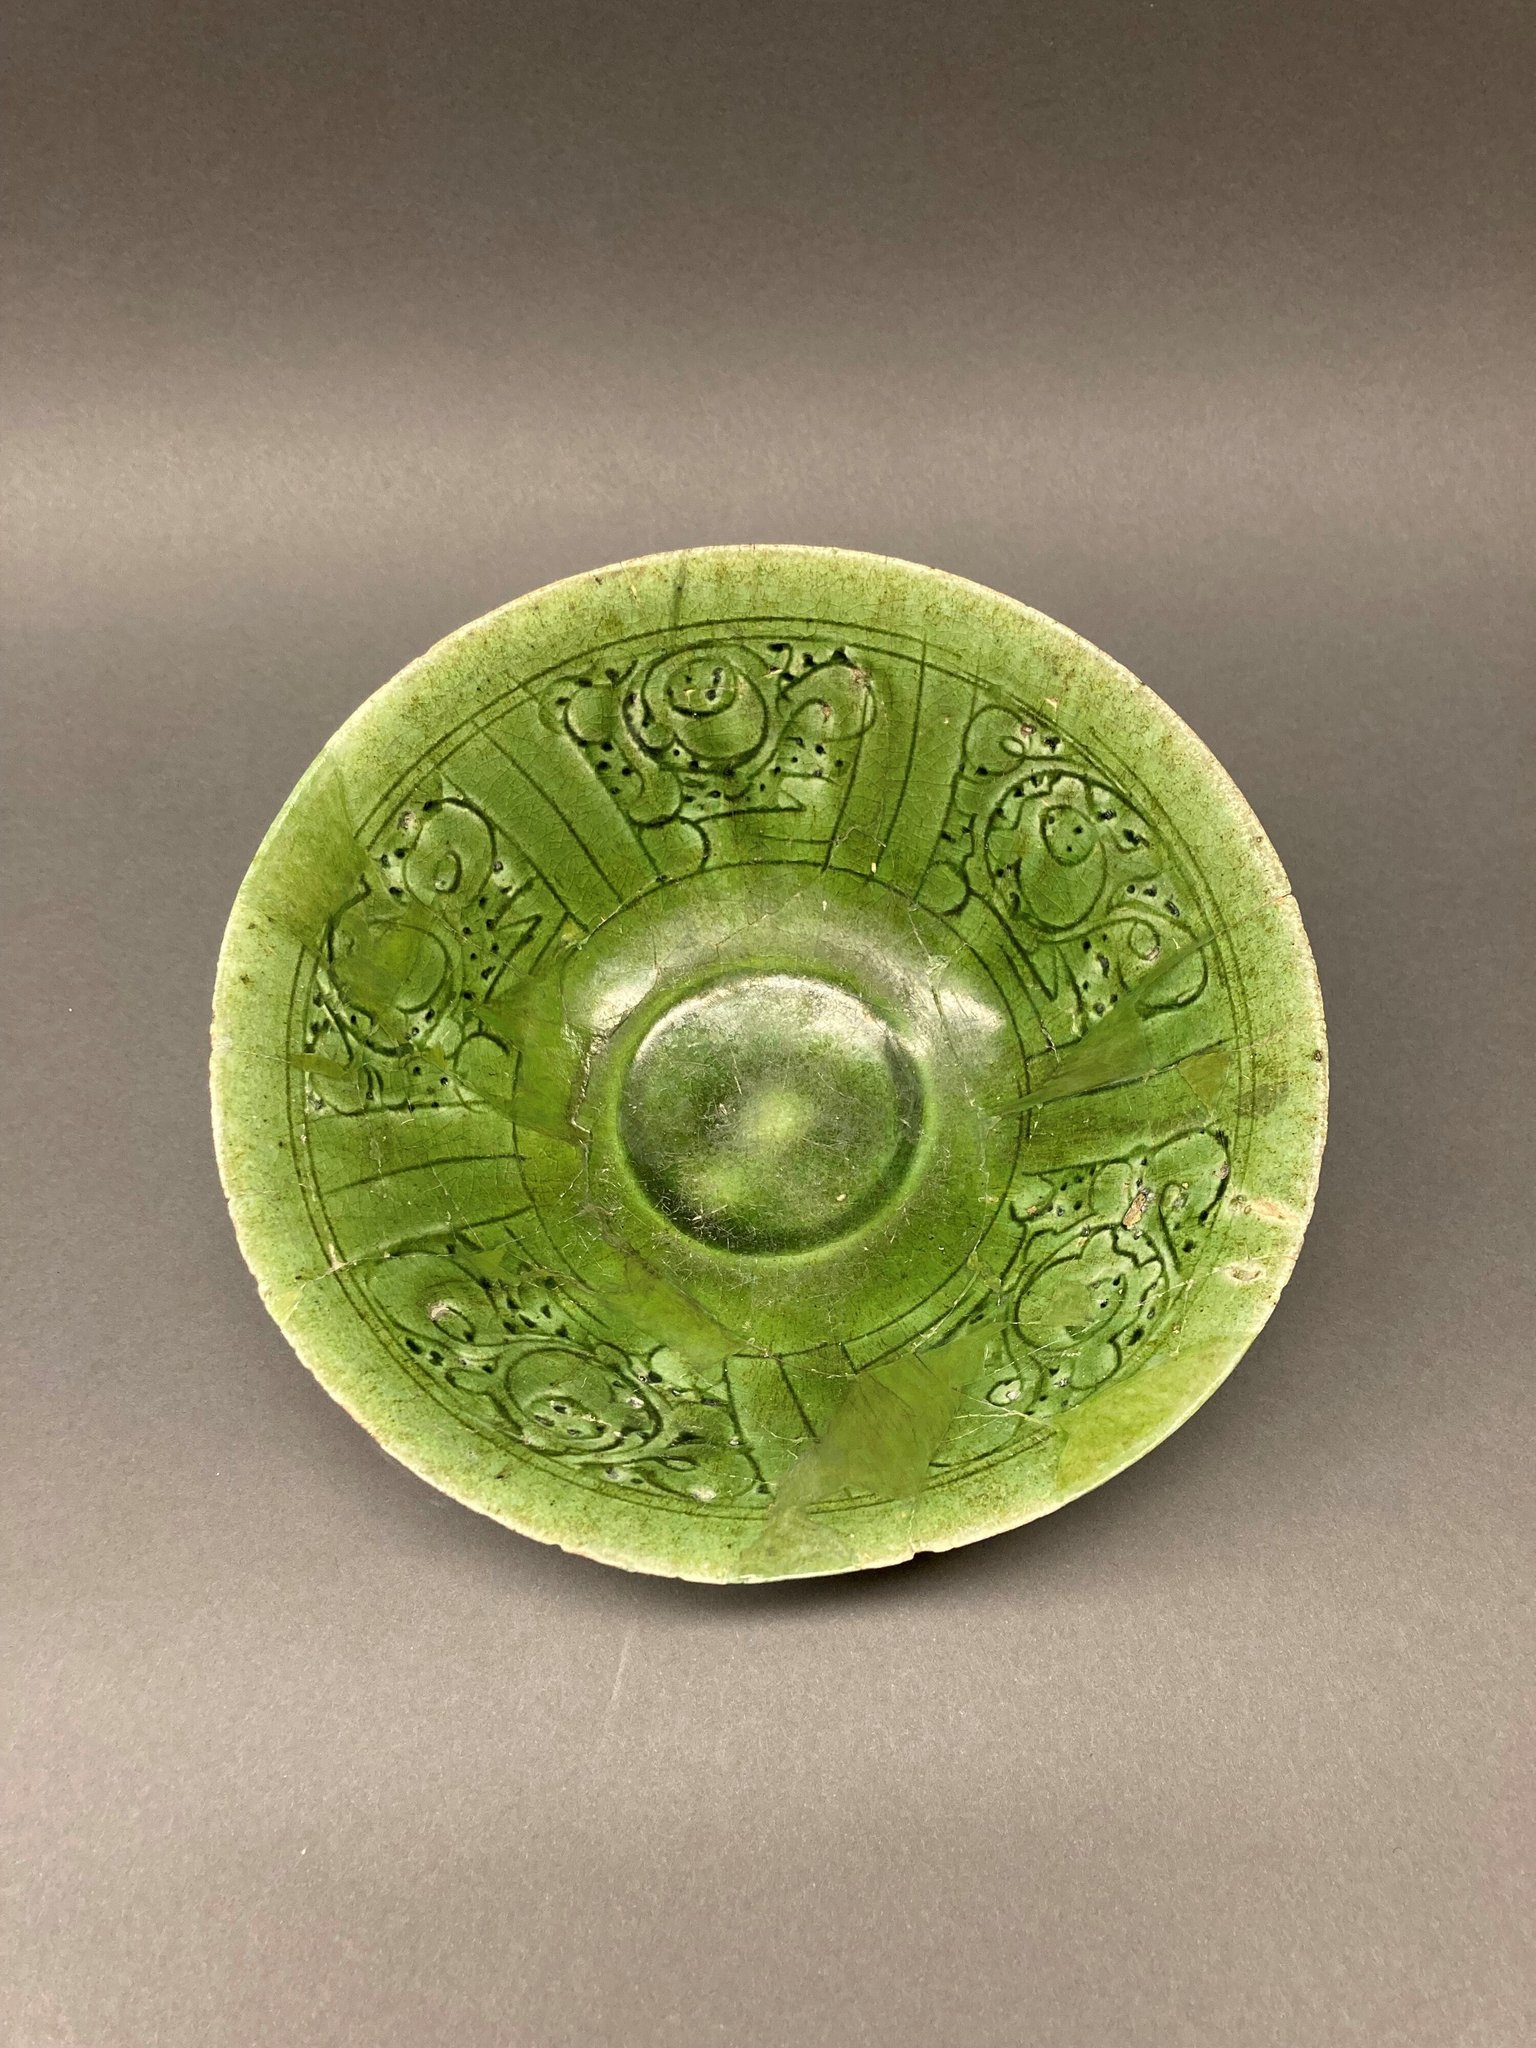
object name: bowl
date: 1101-1300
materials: stonepaste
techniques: incising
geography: iran